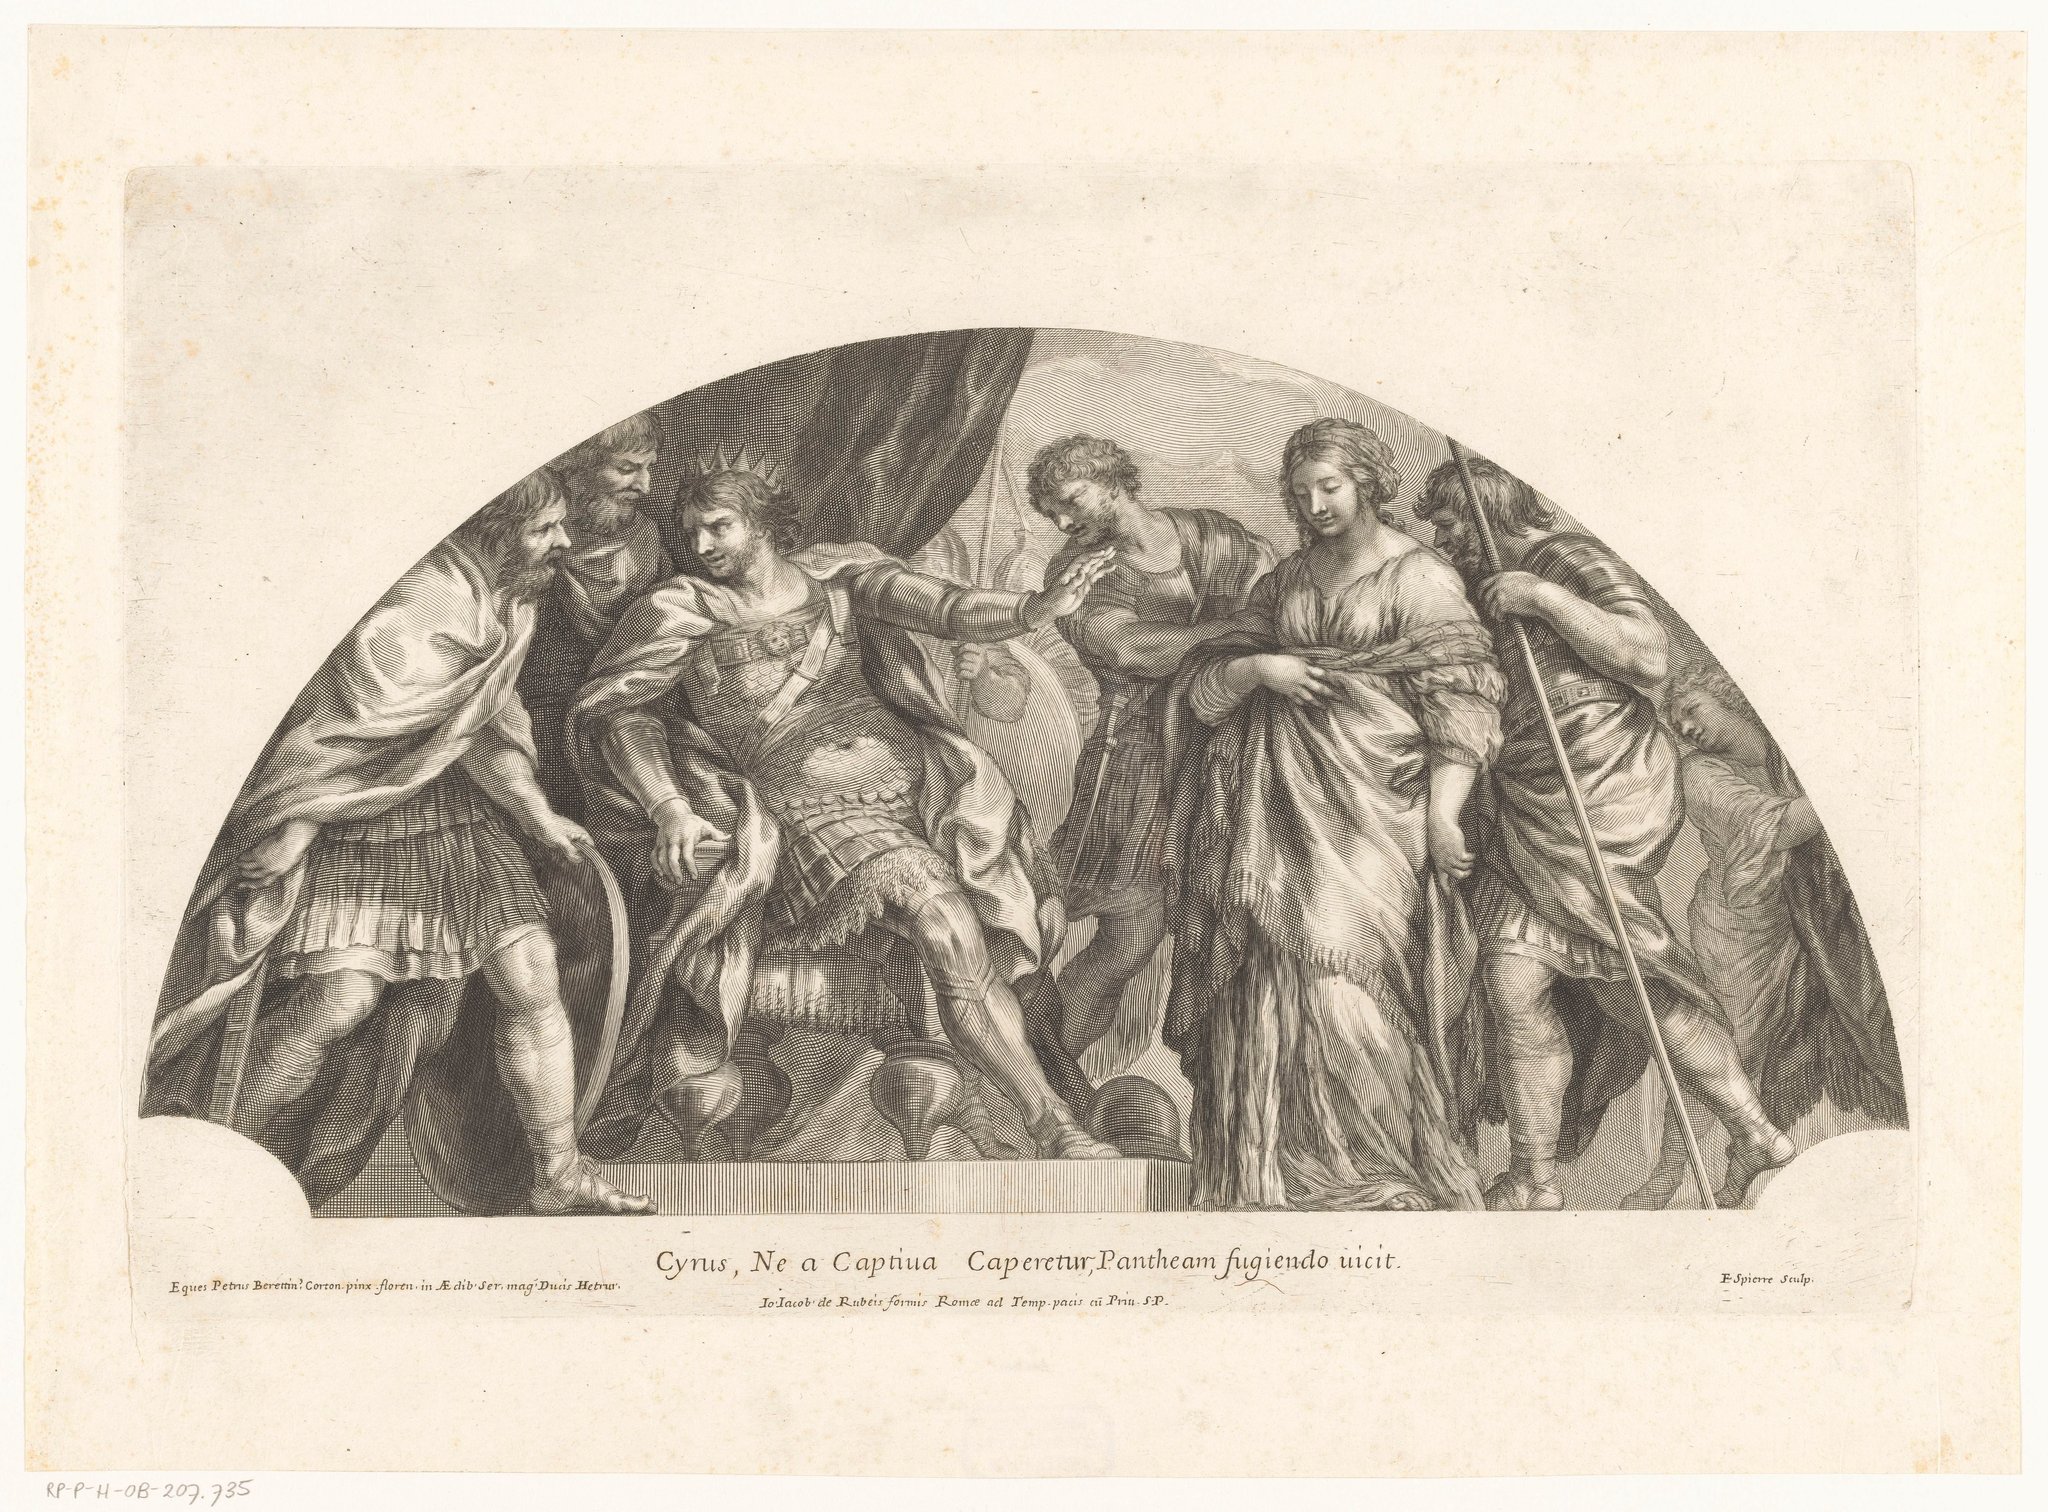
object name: print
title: Cyrus, Ne a Captiva Caperetur, Pantheam fugiendo vicit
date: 1677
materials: paper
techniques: engraving, etching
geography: vatican city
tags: (story of) cyrus king of persia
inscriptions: collector's mark: Lugt 11, collector's mark: ‘Hinloopen’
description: Naar een fresco door Pietro da Cortona in de Sala di Venere in Palazzo Pitti te Florence. De prent maakt deel uit van een reeks van 15 ongenummerde prenten. Deze prent maakte oorspronkelijk deel uit van liber nr. 22 van de Atlas van Rome, uit de collectie Hinloopen. In dit album waren een aantal prentreeksen naar bekende zeventiende eeuwse frescoseries bijeengebonden. In 1709 heeft Schijnvoet op last van de burgemeesters van Amsterdam de collectie herordend. De prenten uit liber 22 kwamen terrecht in Schijnvoet boek nr. 10. De laatst gedateerde reeks in het album is gedateerd 1691. Het album moet dus na deze datum gebonden zijn. De band is in de Rijksakademietijd uit elkaar gehaald. De marges van de prenten zijn bij het opbergen in het Rijksprentenkabinet vaak drastisch afgesneden. Van een aantal series waren de prenten teruggeslagen om in het album te passen. (Zie: Waals, Jan van der. De prentschat van Michiel Hinloopen. 's-Gravenhage: SDU uitgeverij, 1988, pp. 173-174.)